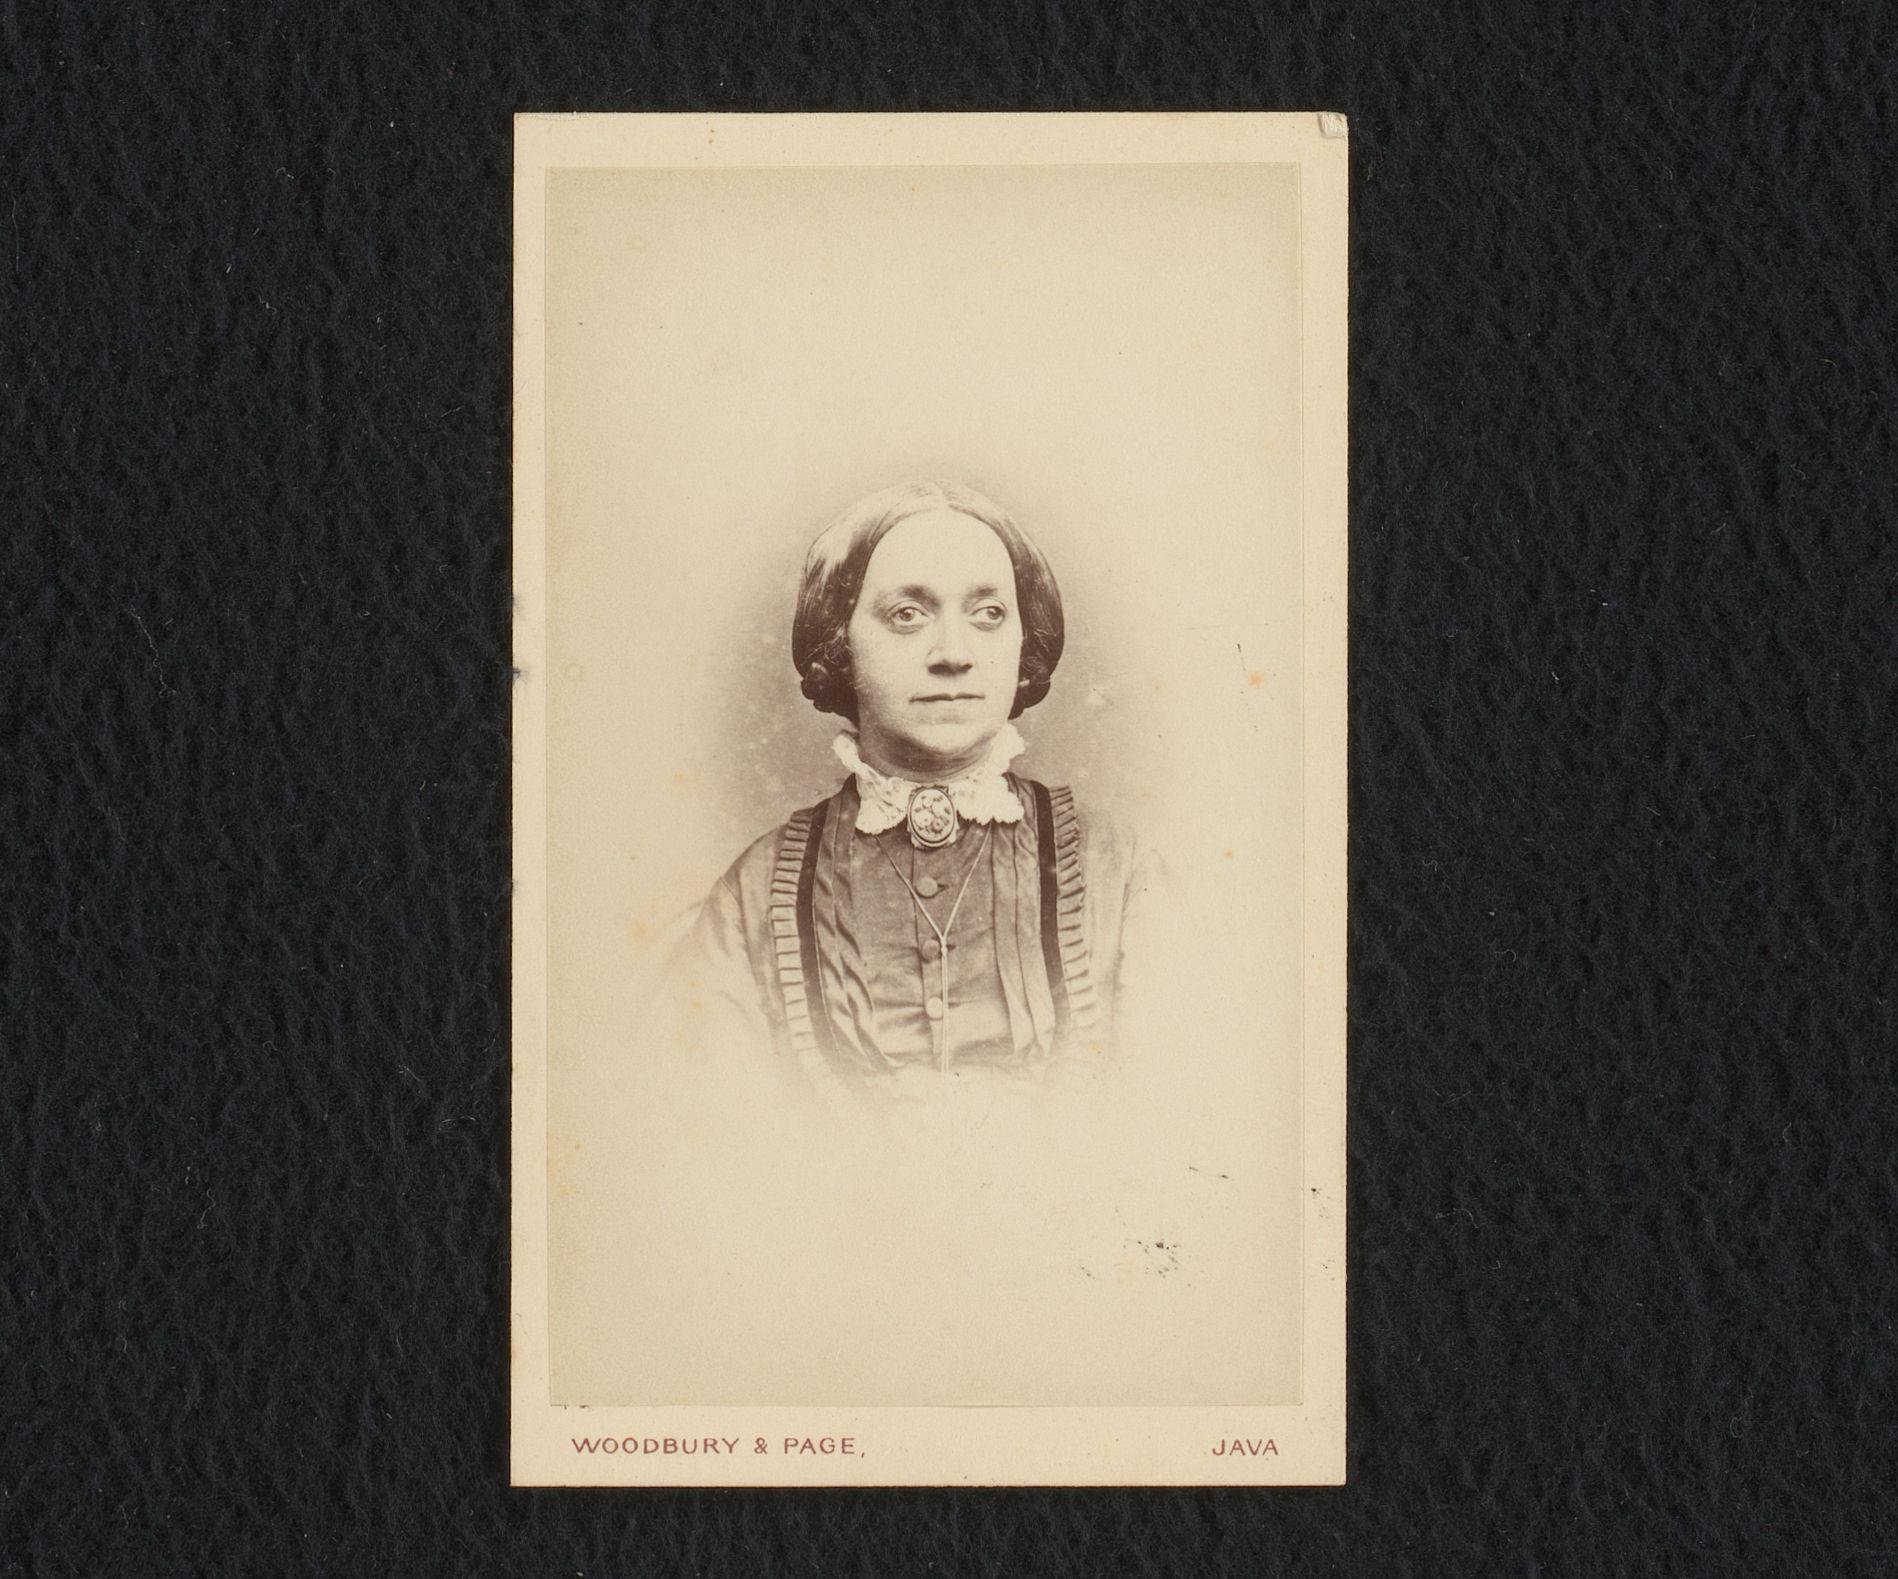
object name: carte de visite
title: Portret van D.H. Schuurman [?]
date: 1877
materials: cardboard, paper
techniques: albumen print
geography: java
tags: historical persons - bb - woman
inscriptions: inscription: ‘Aan mijne lieve Margo/ die ook door dezelfde/ band nu aan ons is verbonden/ van [...] innig liefde/ D.H. Schuurman/ 7 Sept. 77’